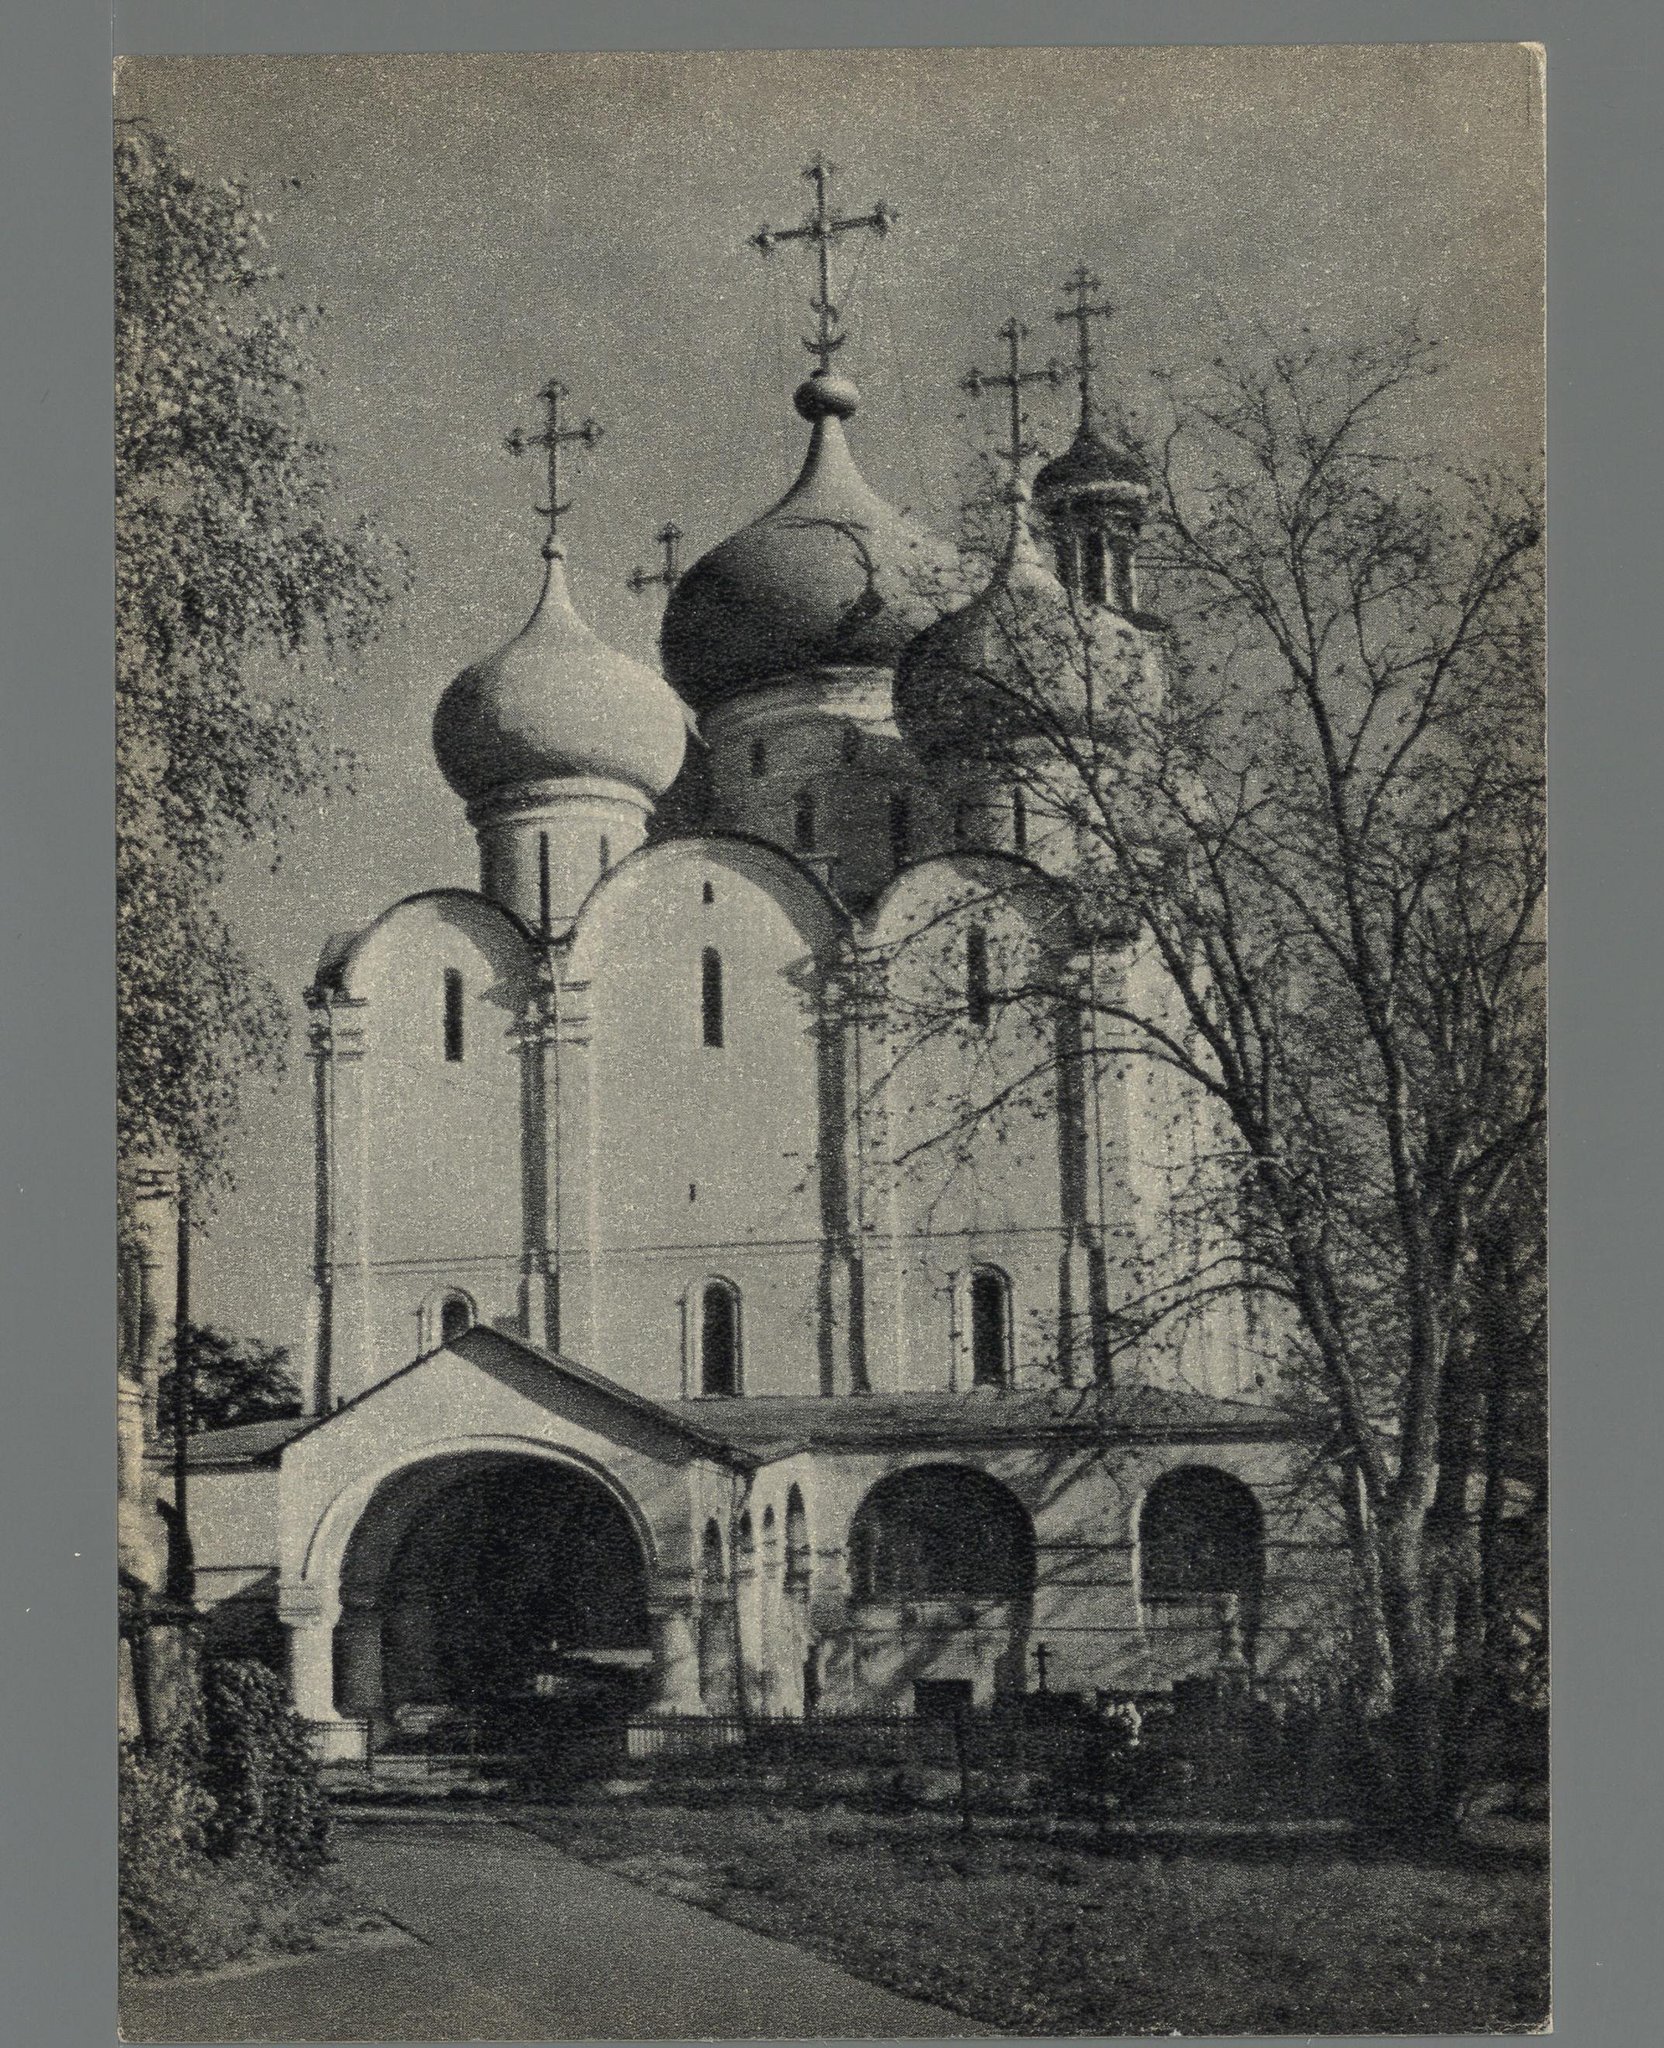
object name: ansichtkaart, prentbriefkaart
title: Gezicht op het Novodevitsjiklooster en de Smolenskykathedraal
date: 1957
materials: cardboard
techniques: rotogravure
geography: moscow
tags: abbey, monastery, convent ~ roman catholic church, church (exterior)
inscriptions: date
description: De titel op object staat in het Russisch.